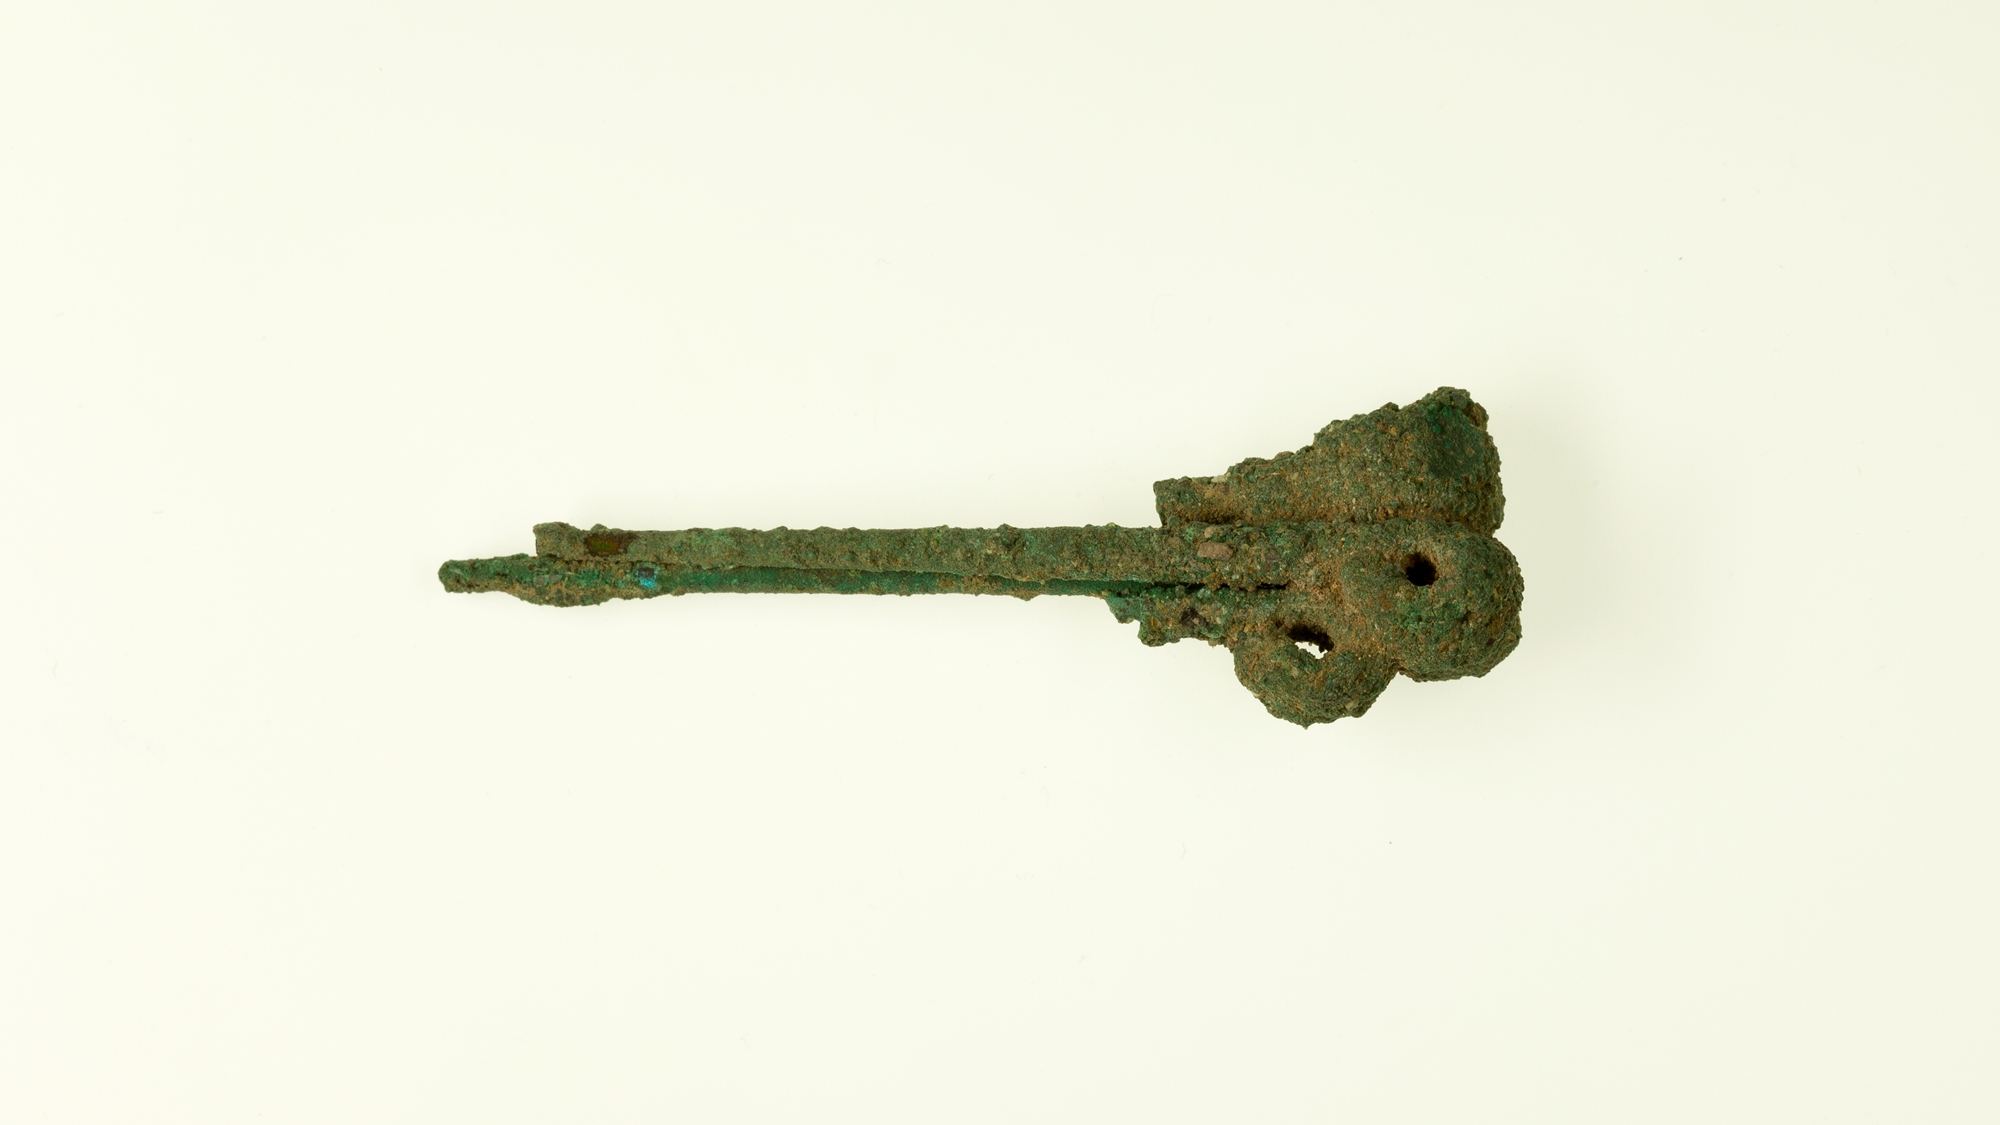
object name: needle, fused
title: Fused needles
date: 1295-1070 BCE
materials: bronze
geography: egypt